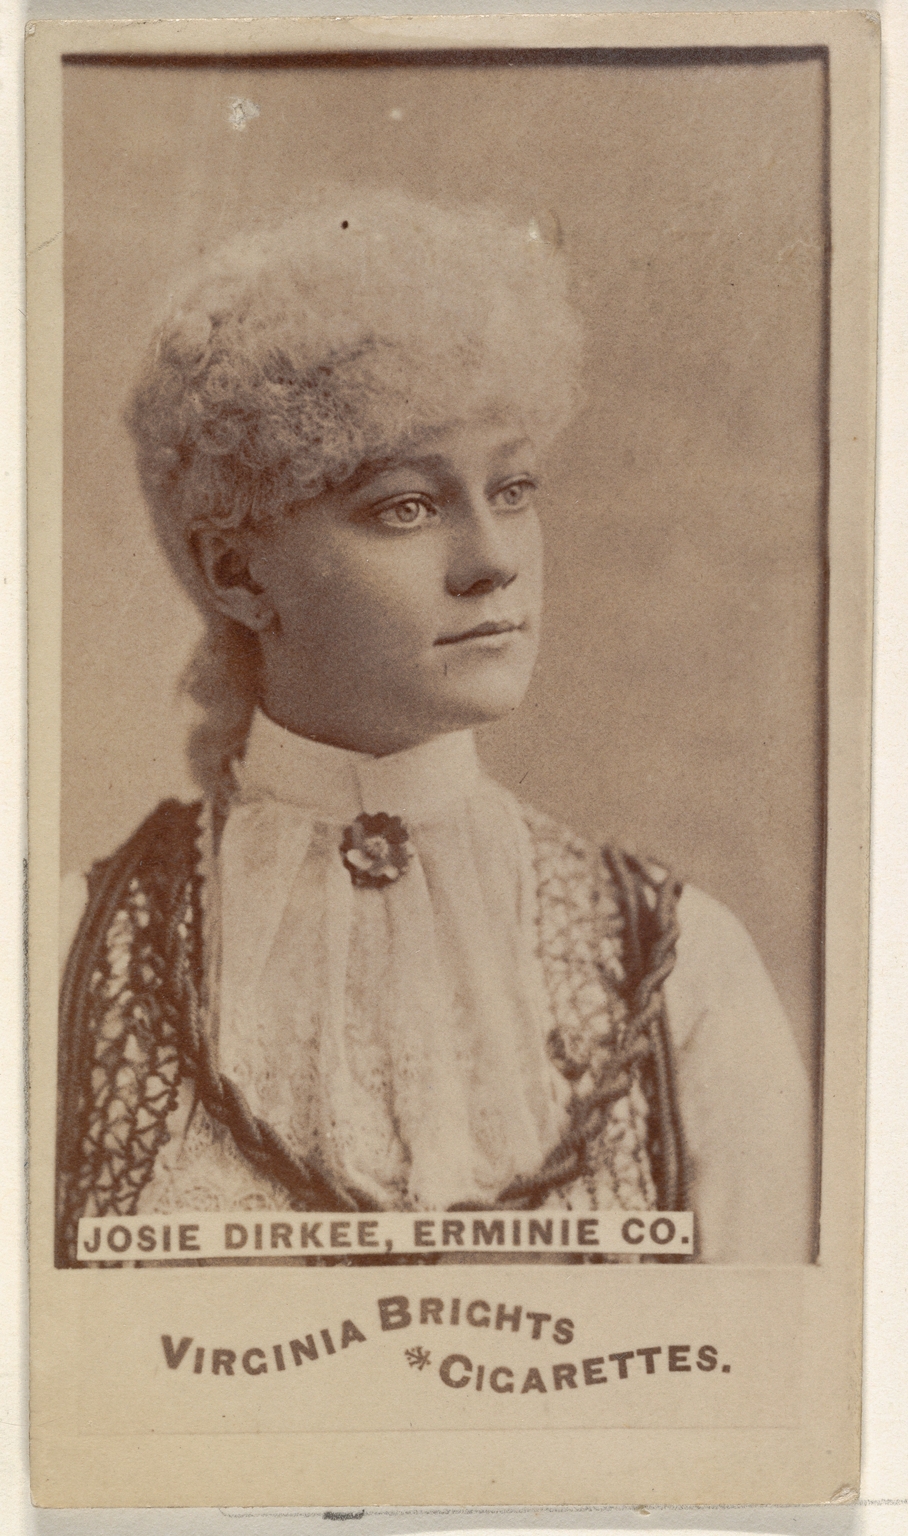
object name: photograph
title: Josie Dirkee, Erminie Co., from the Actors and Actresses series (N45, Type 6) for Virginia Brights Cigarettes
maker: allen & ginter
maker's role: publisher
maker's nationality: american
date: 1888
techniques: albumen silver print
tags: portraits,women,actresses